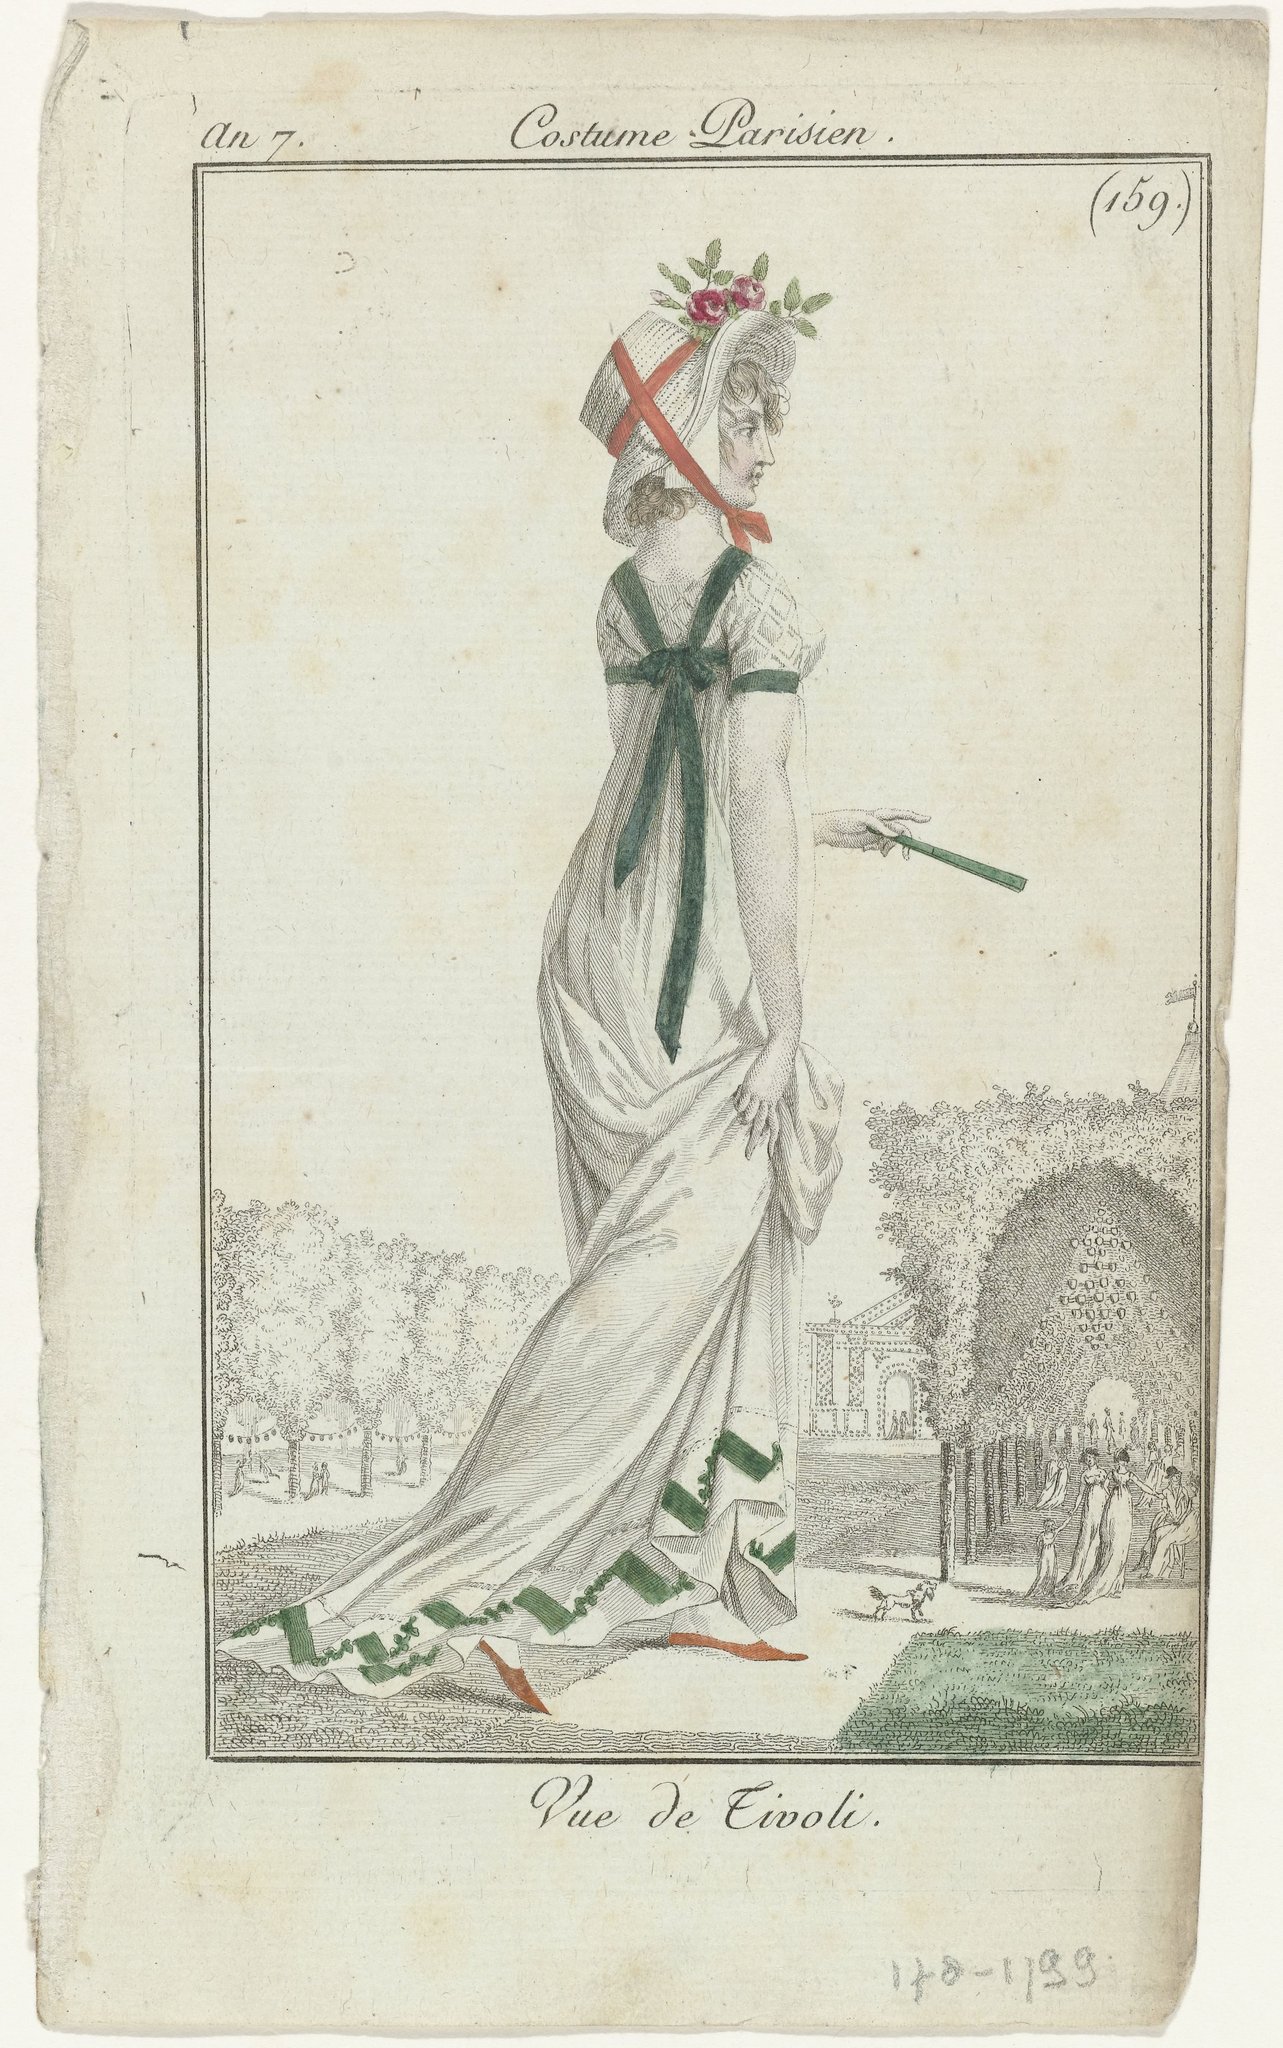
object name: fashion print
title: Journal des Dames et des Modes, Costume Parisien, 22 septembre 1799, An 7, (159.) : Vue de Tivoli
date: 1799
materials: paper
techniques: engraving, hand coloring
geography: paris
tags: park, head-gear (+ women's clothes), fashion plates, shoes, sandals (+ women's clothes), dress, gown (+ women's clothes), fan (+ women's clothes)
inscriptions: caption: ‘Vue de Tivoli.’, title: ‘Costume Parisien.’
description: Vrouw, half op de rug gezien, lopend door de tuinen van Tivoli, gekleed in een japon met een geruit lijfje. Gestrikt lint op de rug, zoom versierd met een geometrisch motief. Korte mouwen en sleep. Accessoires: hoed versierd met bloemen, waaier, platte schoenen met puntige neuzen. Met de rechterhand houdt ze haar japon op. De prent maakt deel uit van het modetijdschrift Journal des Dames et des Modes, uitgegeven door Pierre de la Mésangère, Parijs, 1797-1839.